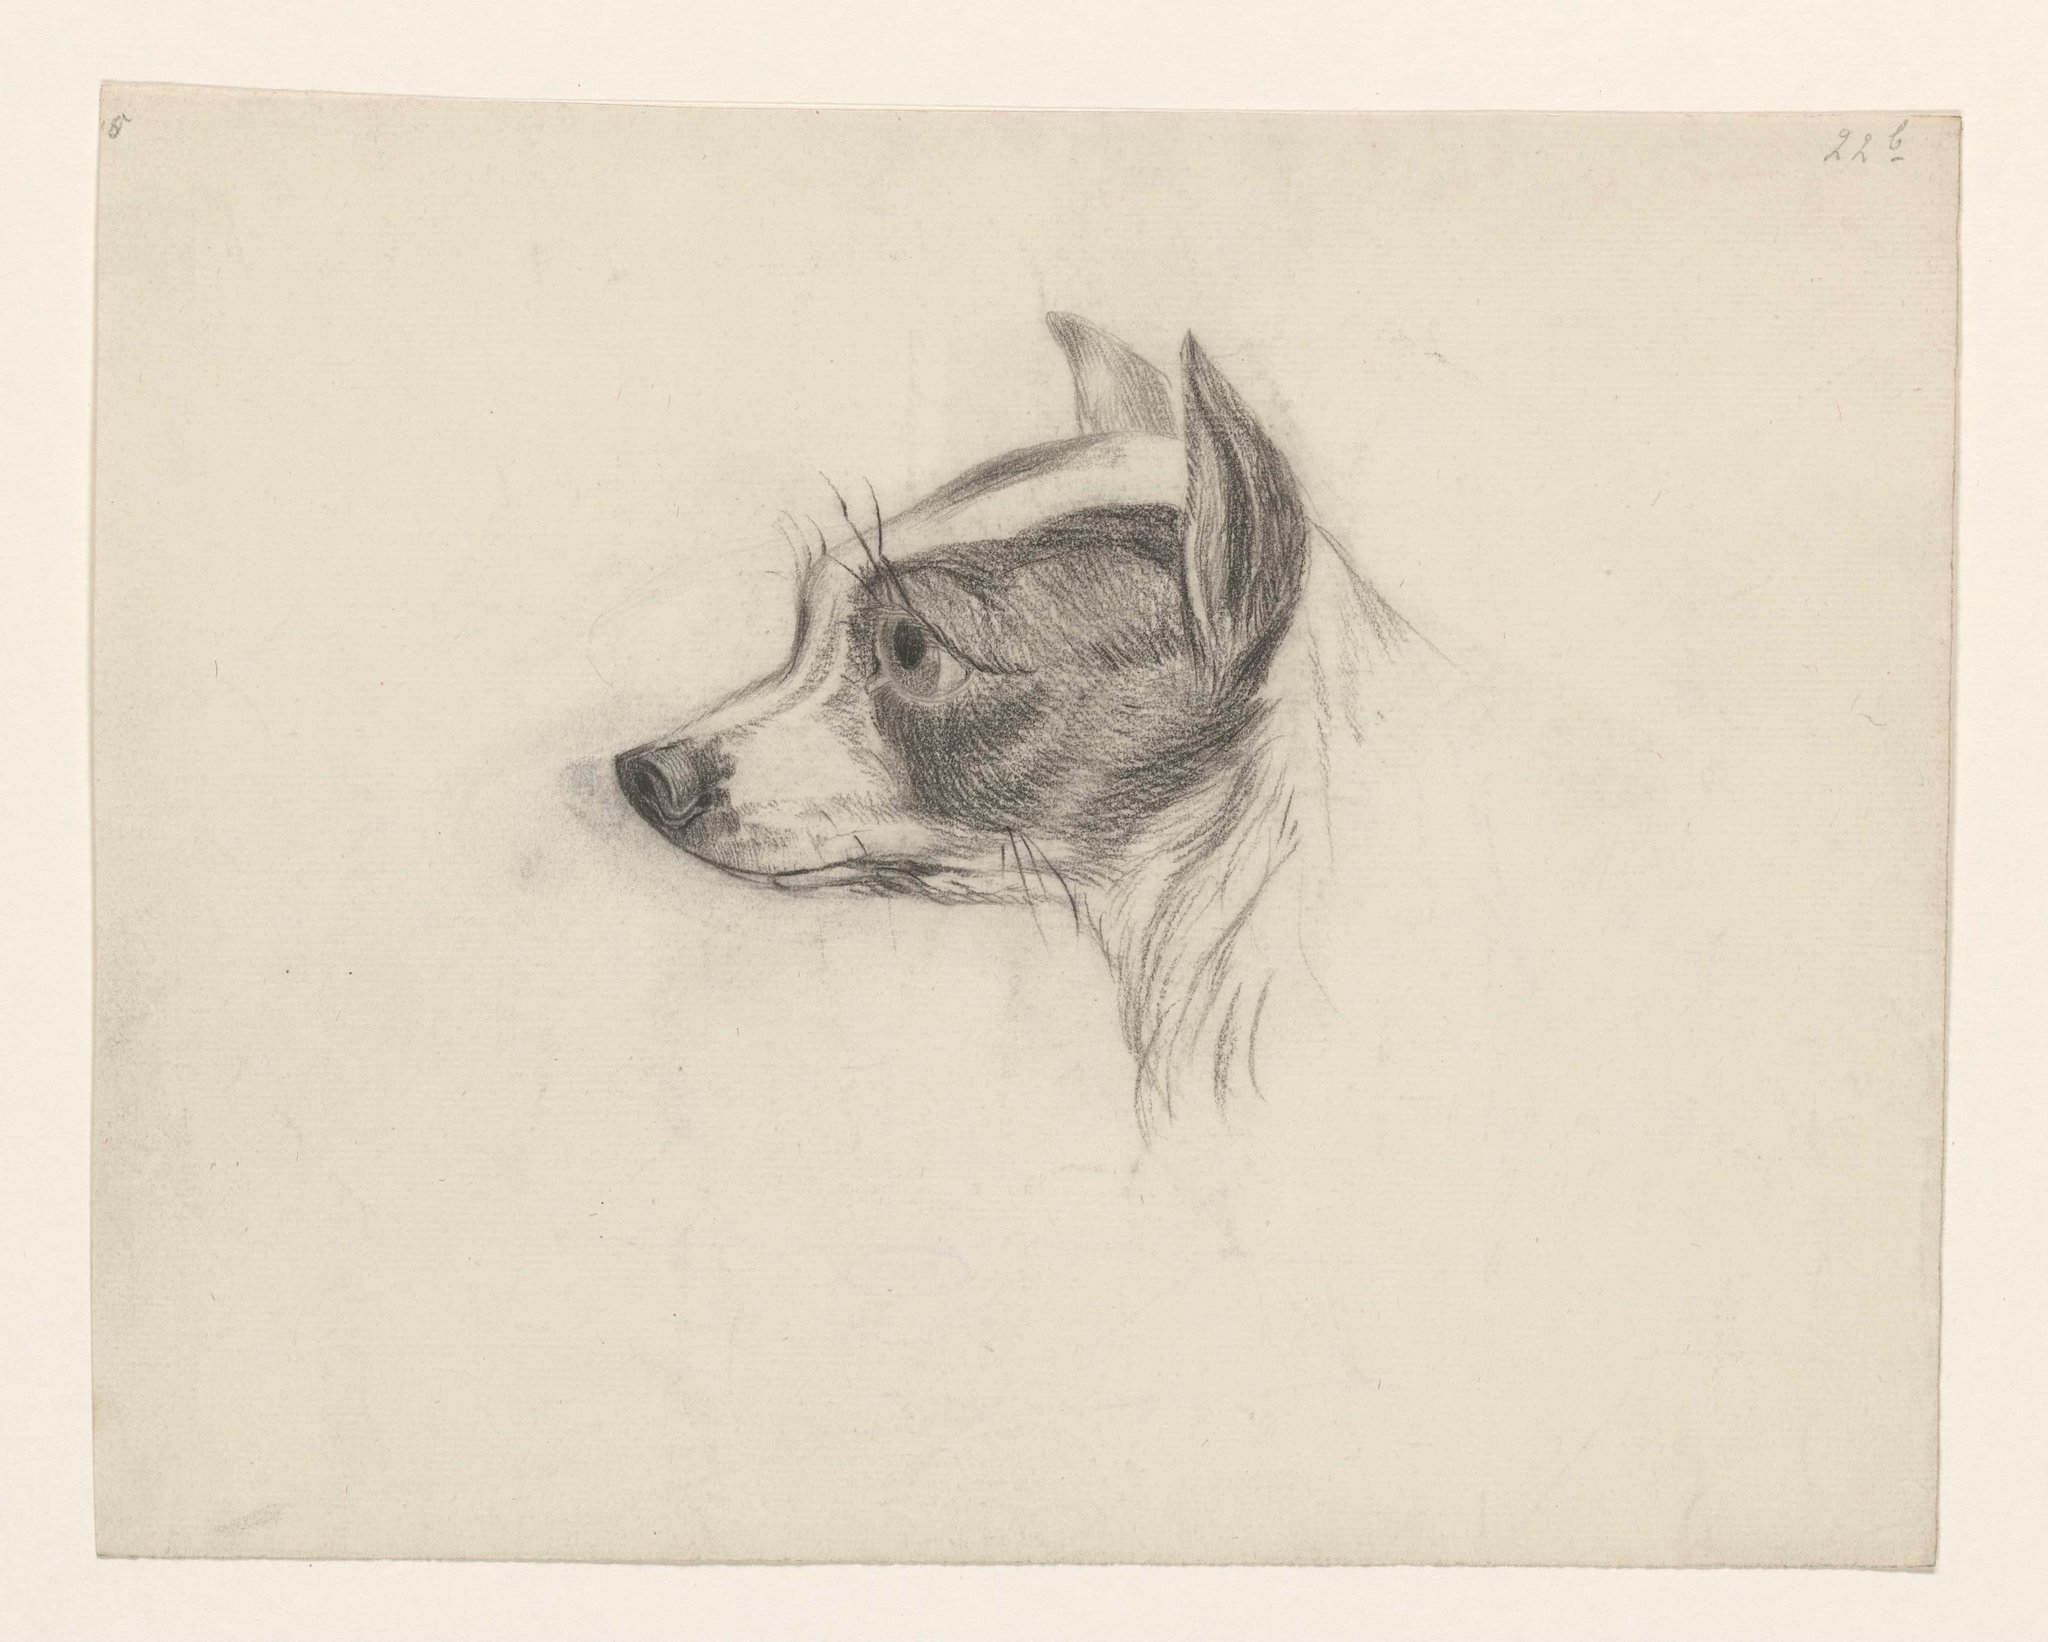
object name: drawing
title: Kop van een hond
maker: johannes tavenraat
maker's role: draughtsman, painter, print maker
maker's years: 1809-1881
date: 1819-1881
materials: chalk, paper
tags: dog